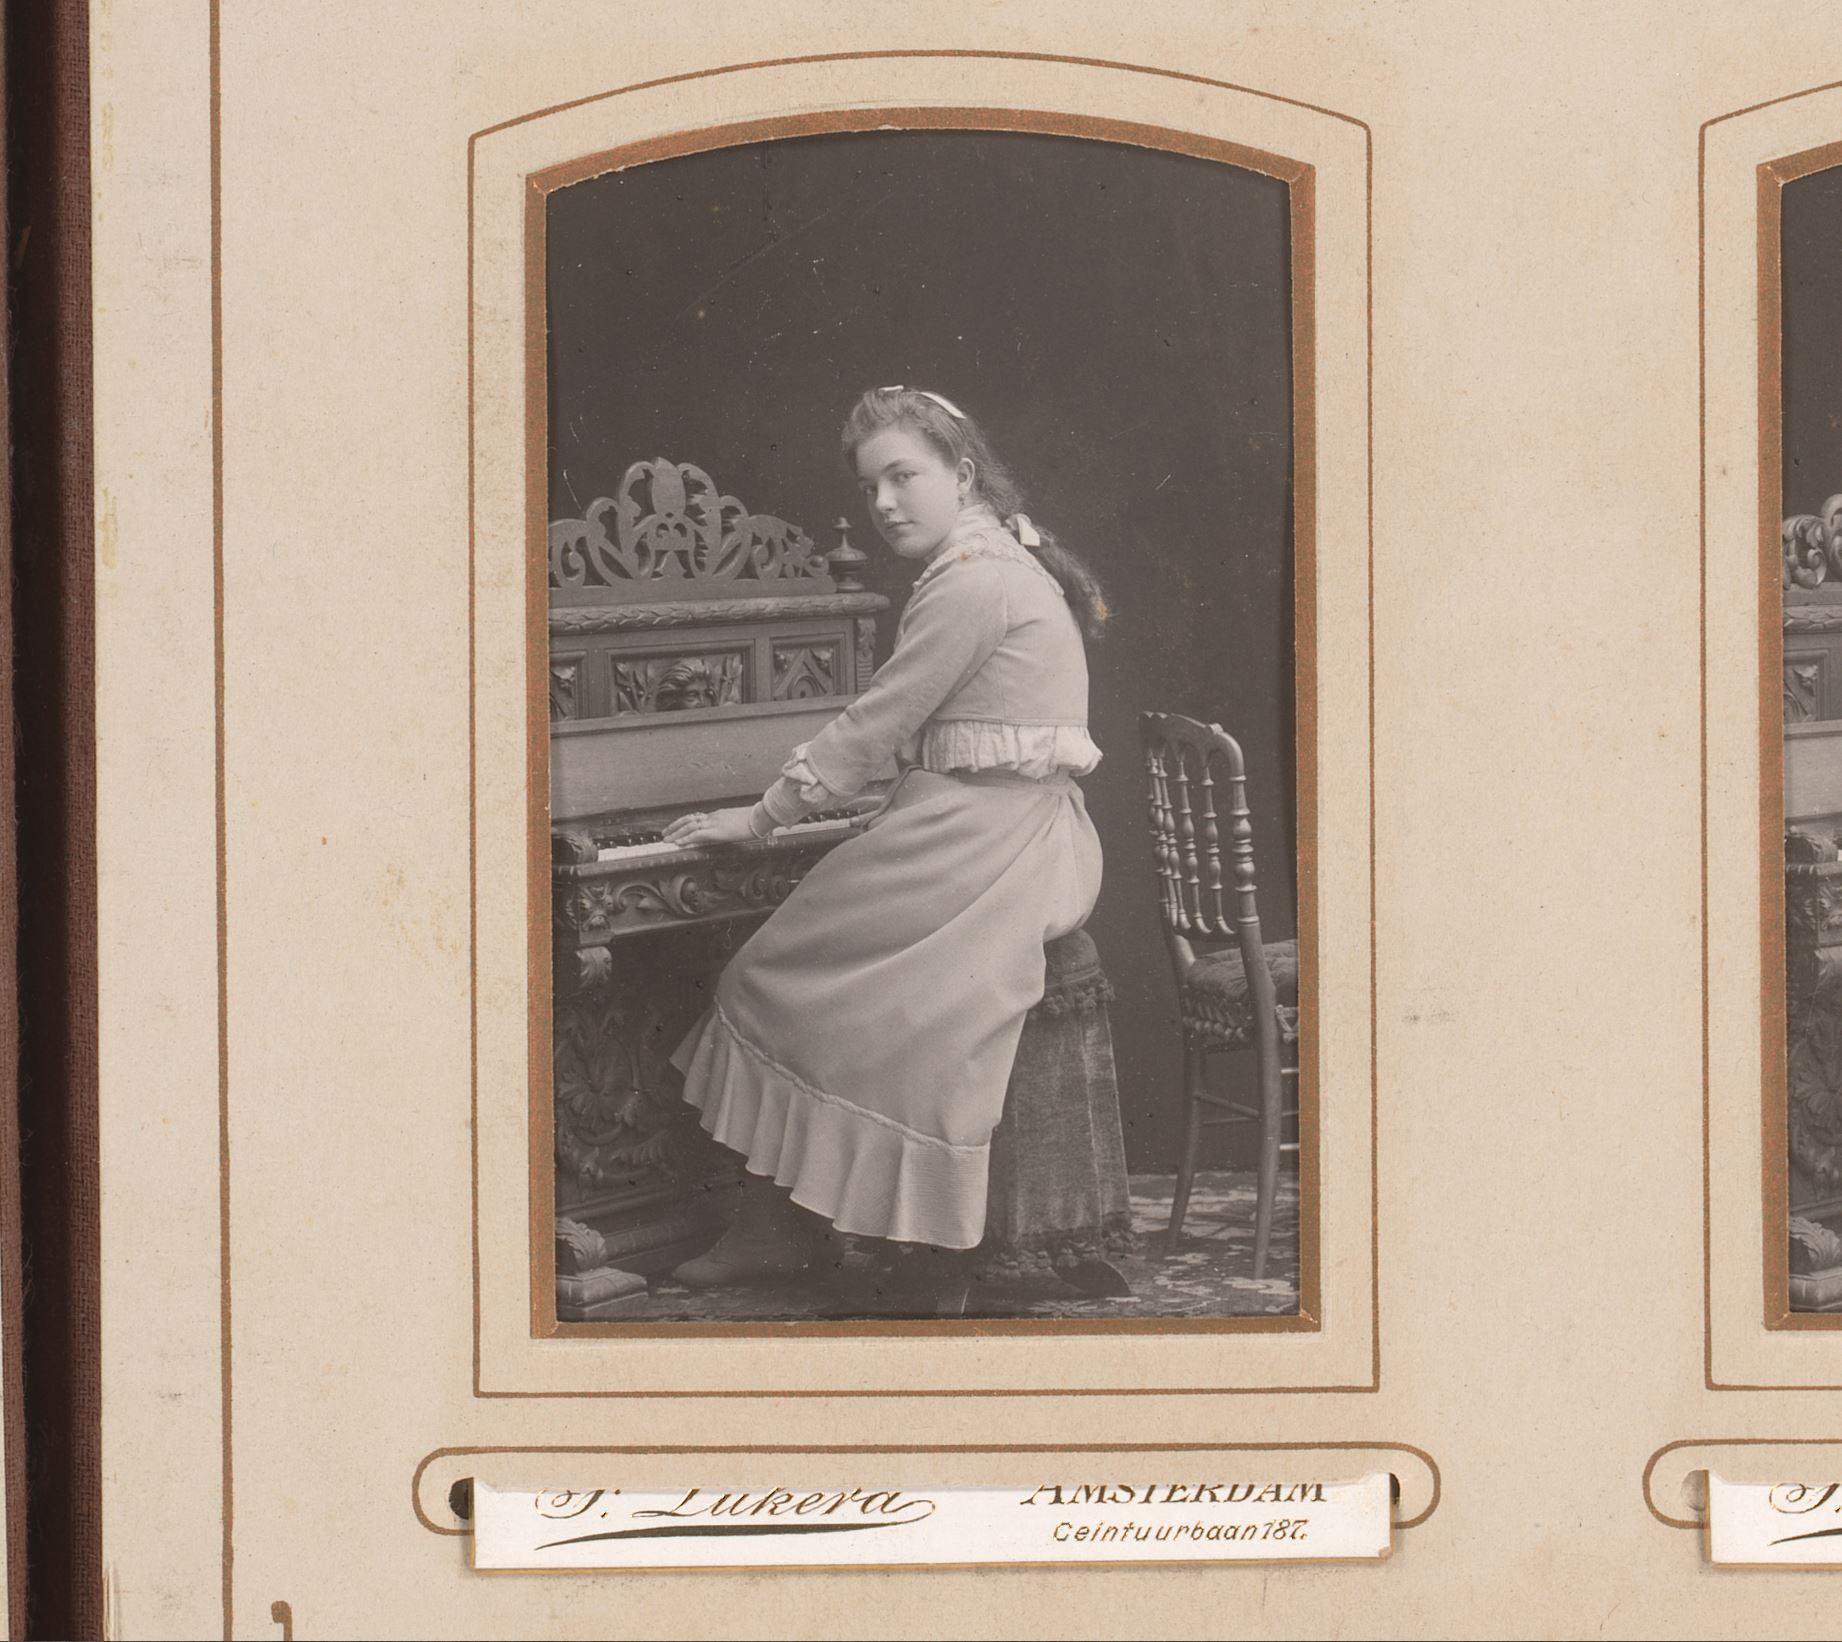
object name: photograph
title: Portret van een meisje, zittend aan een piano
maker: franciscus g. lukera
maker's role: fotograaf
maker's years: 1853-1927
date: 1880-1927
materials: cardboard, photographic support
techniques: collodion silver print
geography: amsterdam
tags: one person playing keyboard instrument, sitting figure - aa - female human figure, girl (child between toddler and youth)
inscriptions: inscription: ‘F. Lukera/ Photograaf/ Ceintuurbaarn 187/ bij de van Woustraat/ Amsterdam’